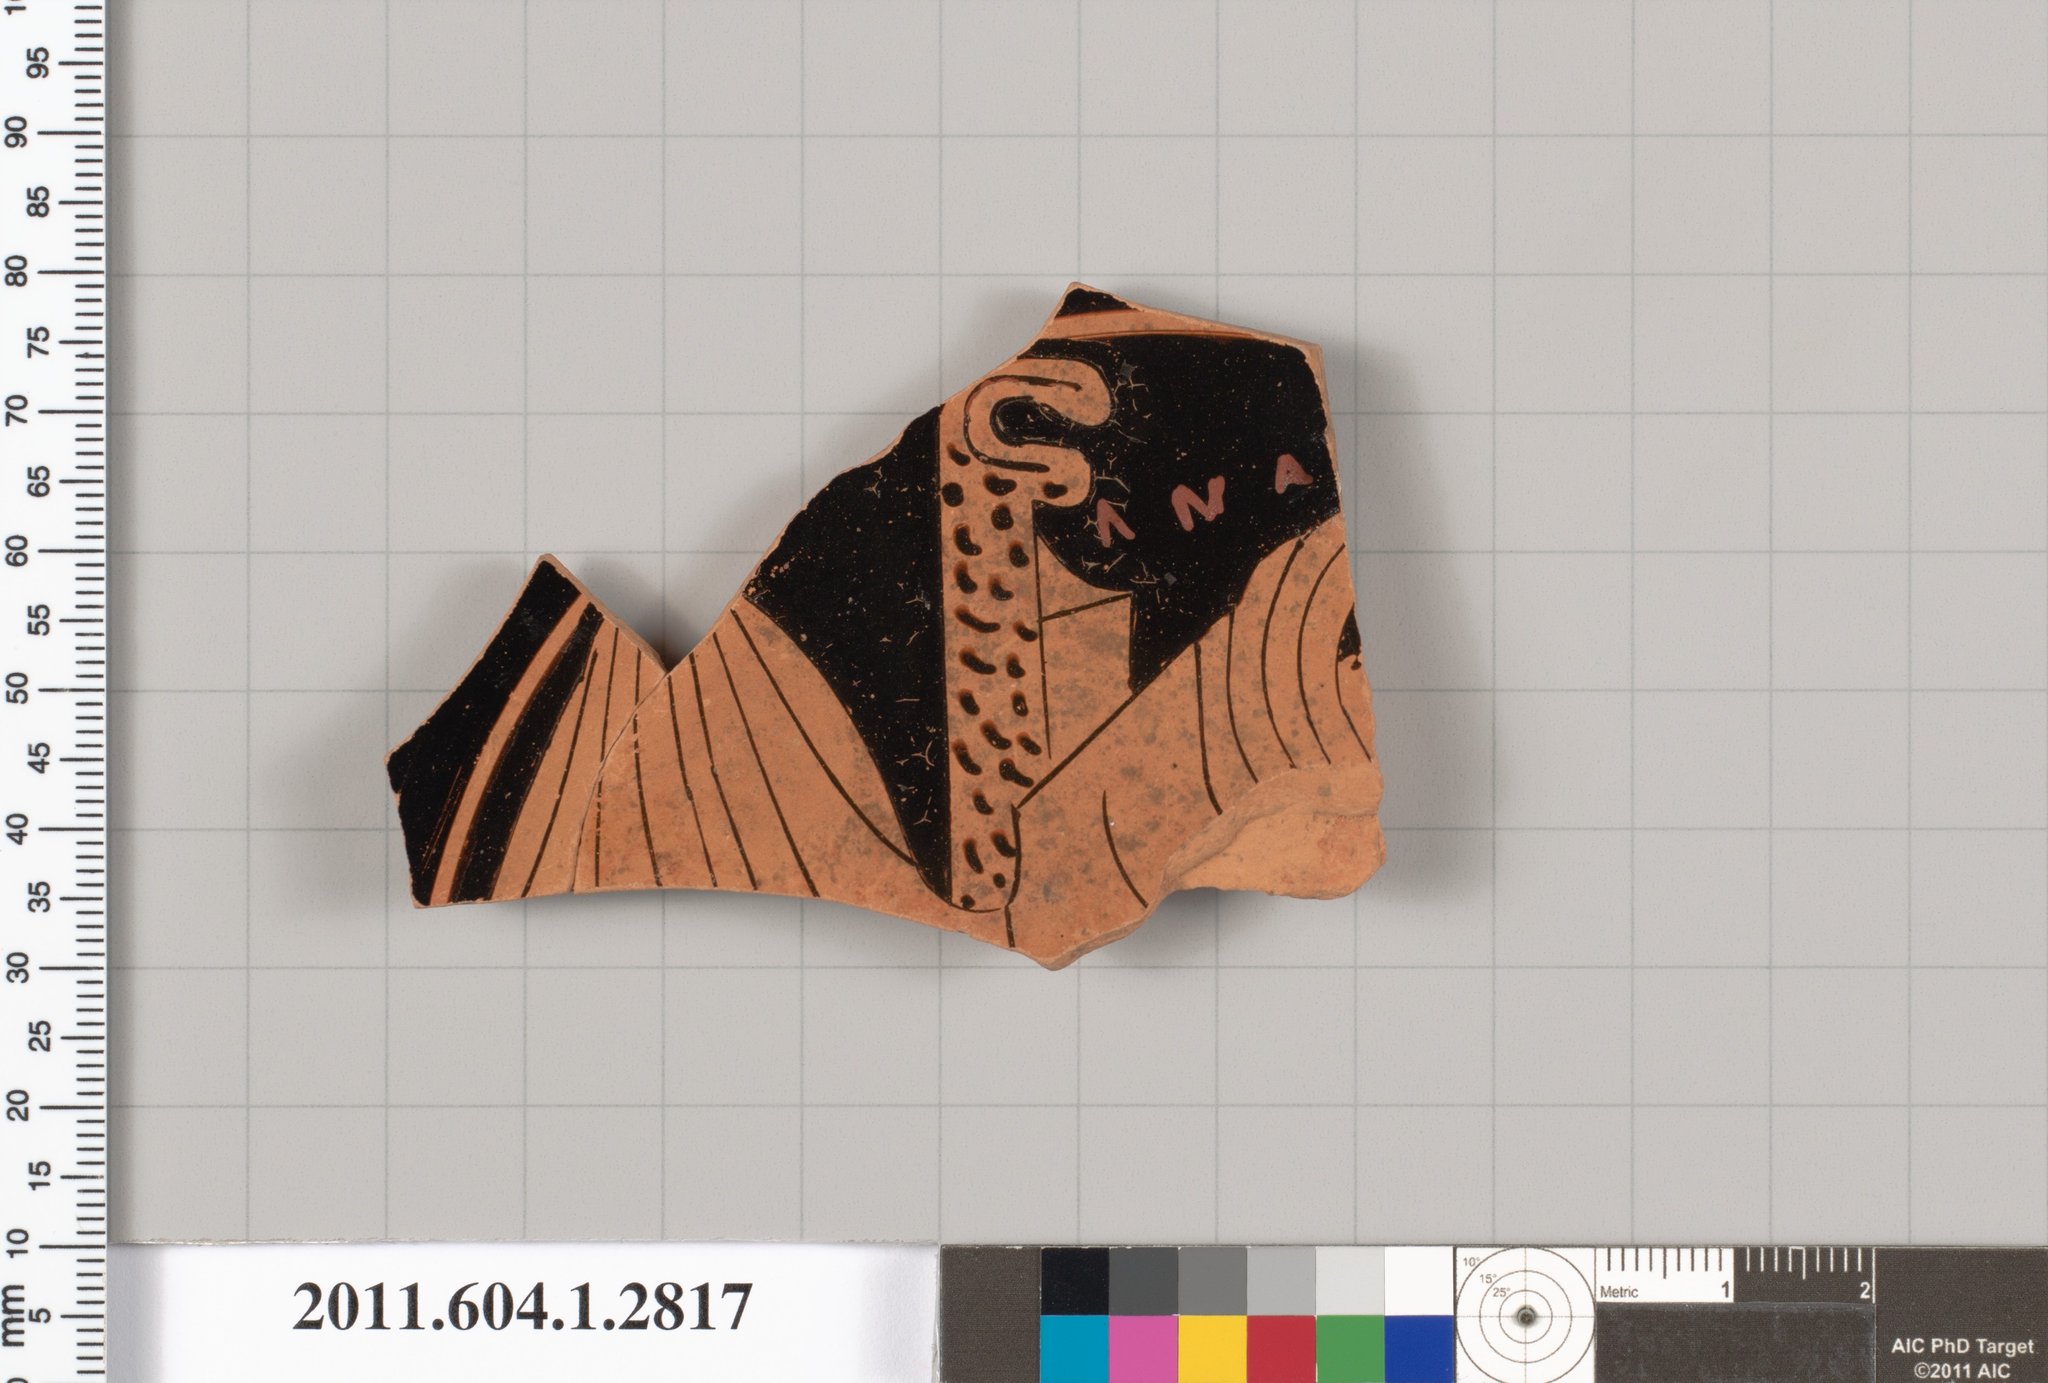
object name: kylix fragment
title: Terracotta fragment of a kylix (drinking cup)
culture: greek, attic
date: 520-500 BCE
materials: terracotta